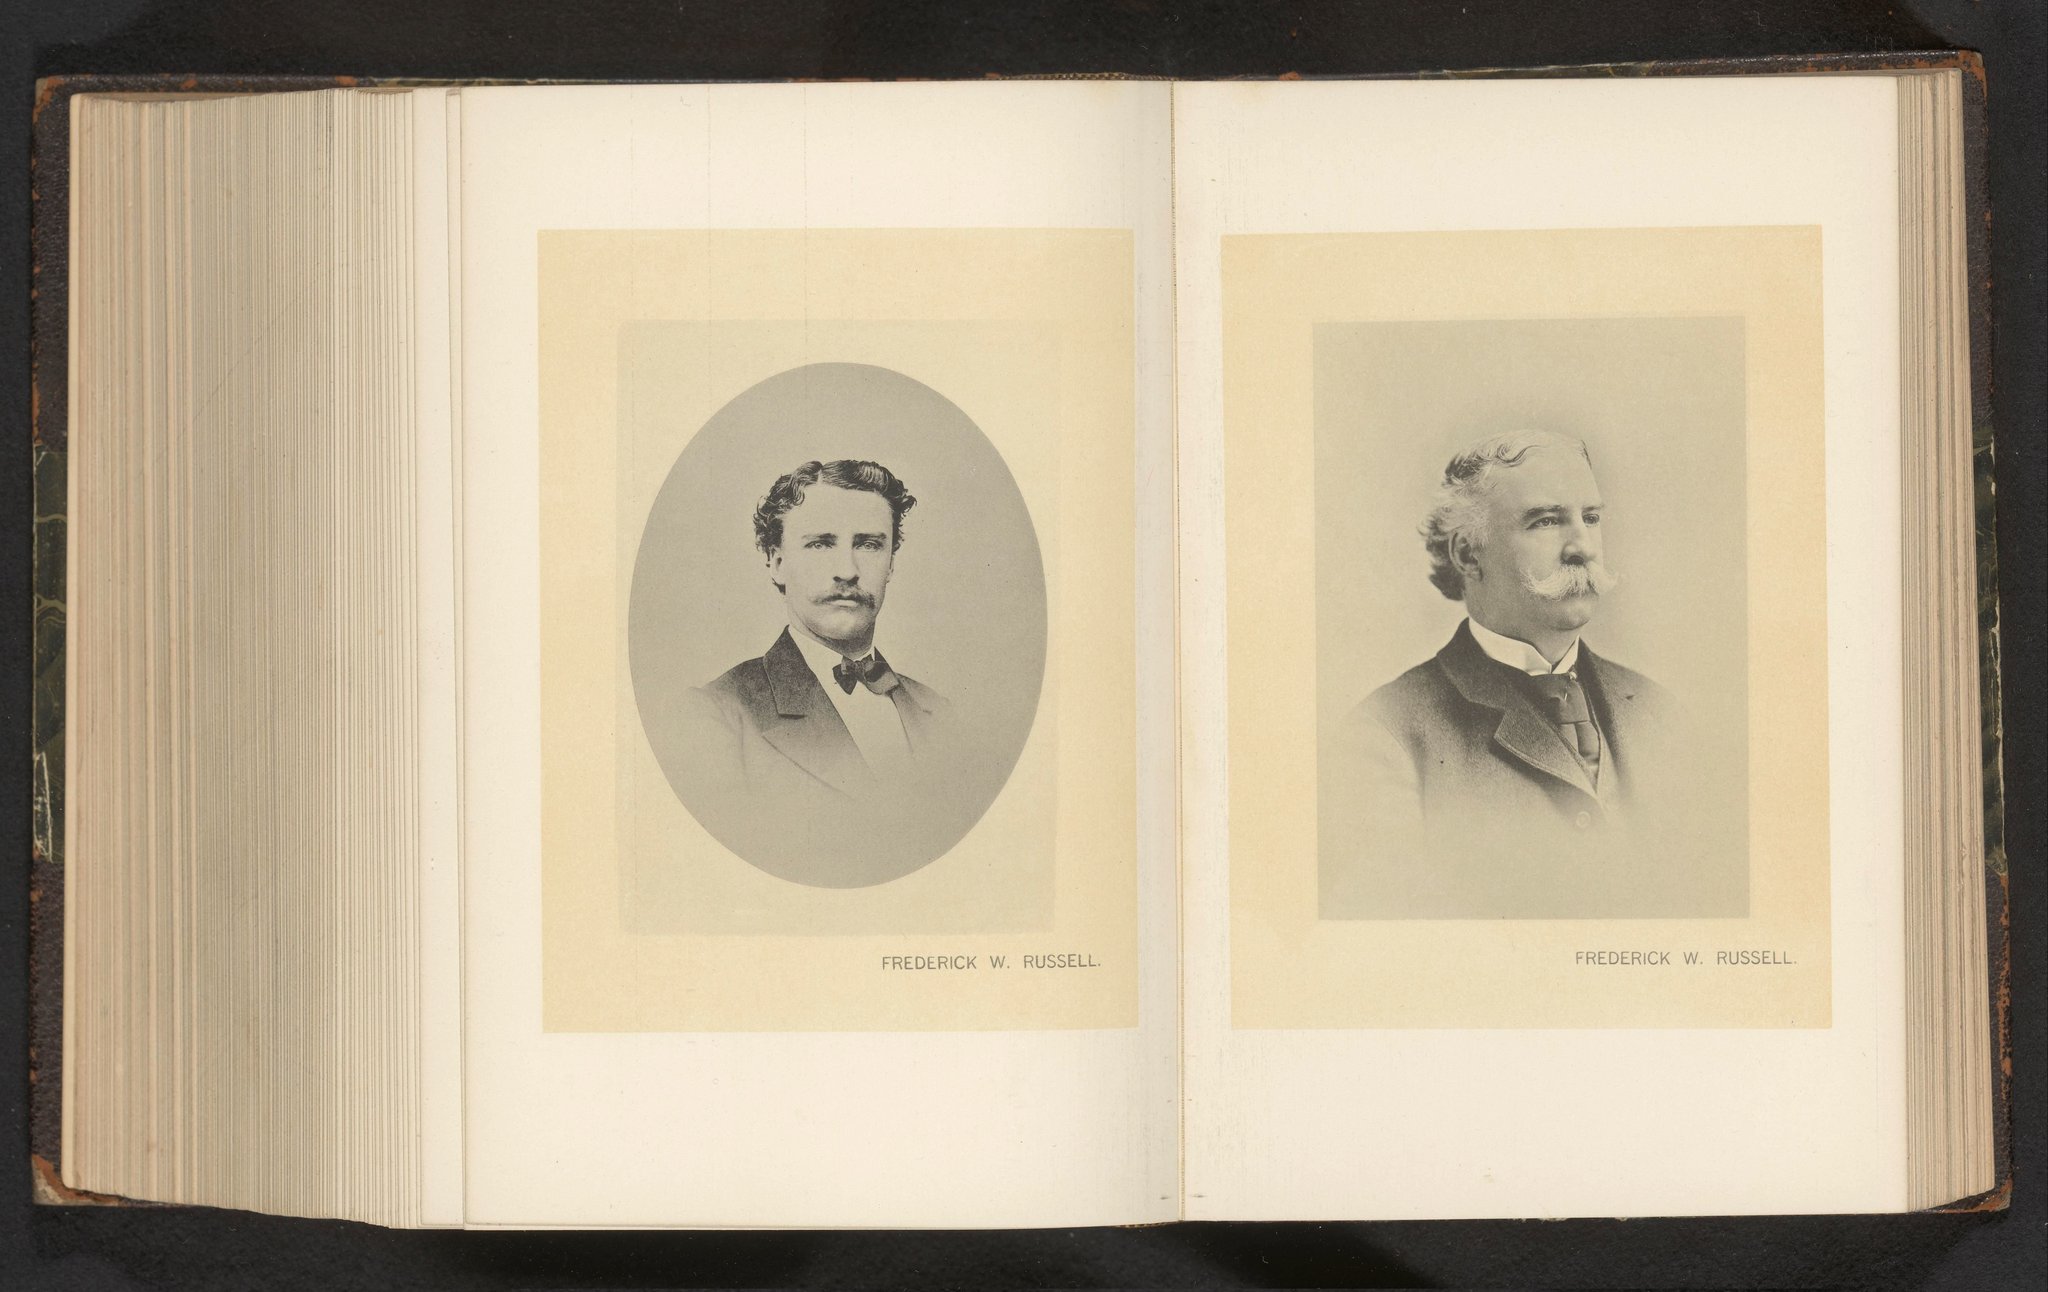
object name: photomechanical print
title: Frederick W. Russell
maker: Anonymous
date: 1889-1894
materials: paper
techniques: photoaquatint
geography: boston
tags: adult man